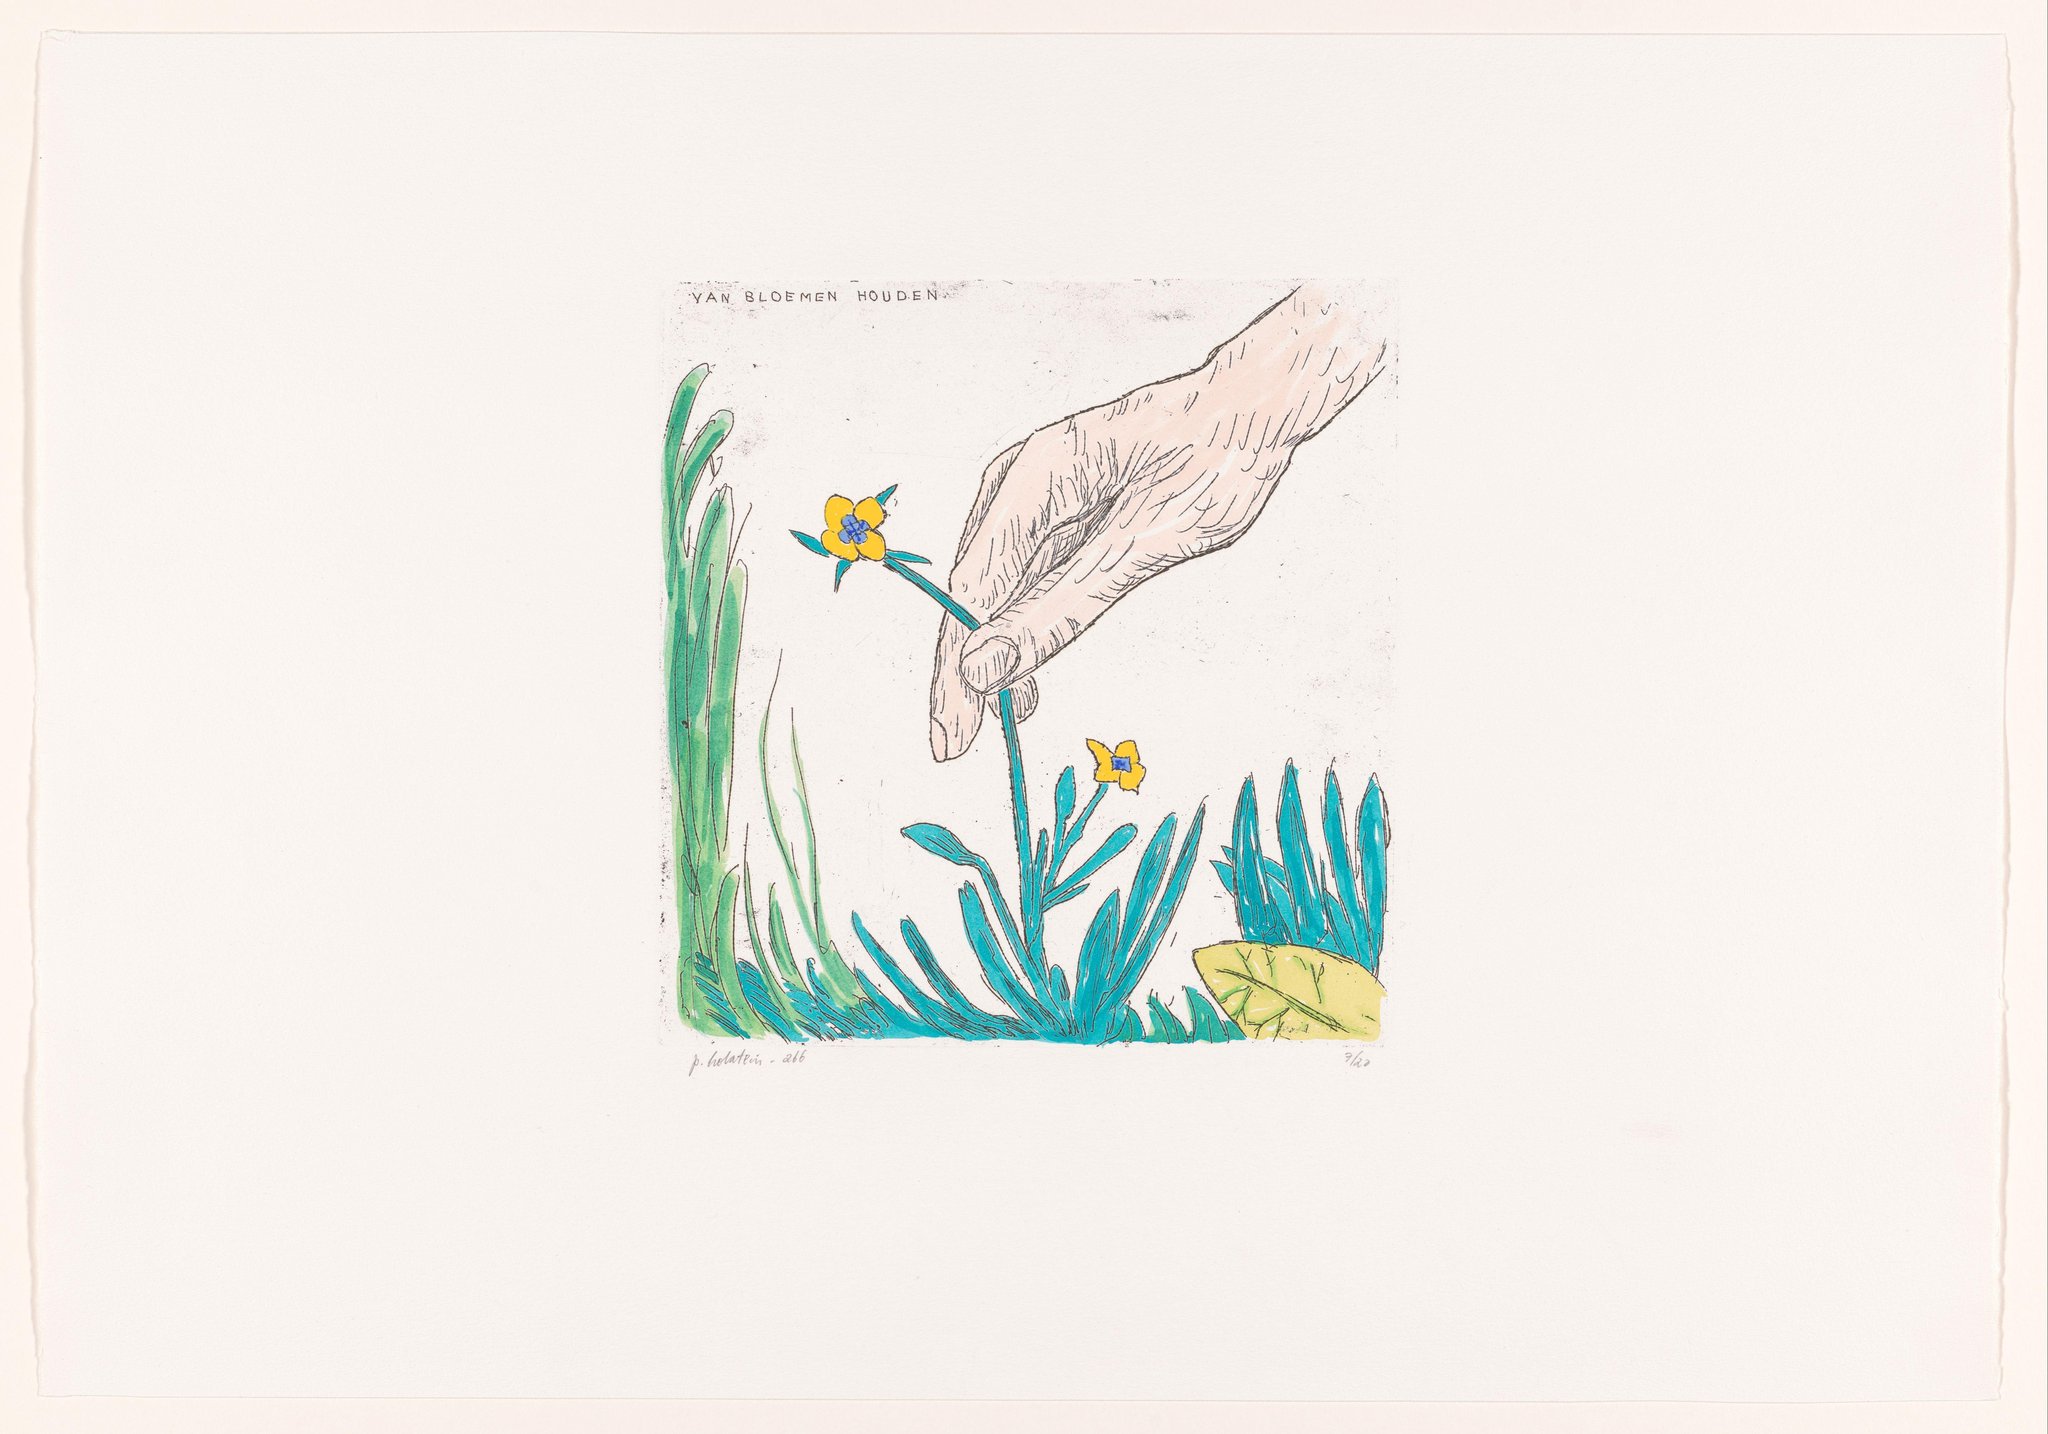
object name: print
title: Van bloemen houden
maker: pieter holstein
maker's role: draughtsman, painter, print maker, sculptor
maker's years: 1934-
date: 1981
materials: paper, watercolor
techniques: brush, etching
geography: amsterdam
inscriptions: edition: ‘7/20’, inscription: ‘266’, signature: ‘p. holstein’, title: ‘VAN BLOEMEN HOUDEN’